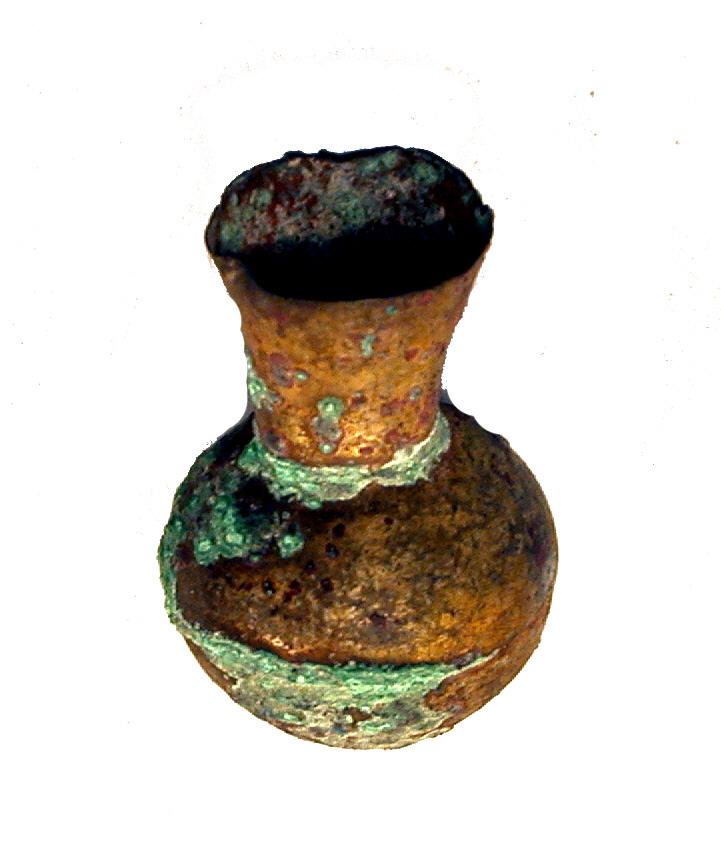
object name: bottle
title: Miniature Bottle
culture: chancay or chimú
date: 1001-1500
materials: copper, silver gilt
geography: peru